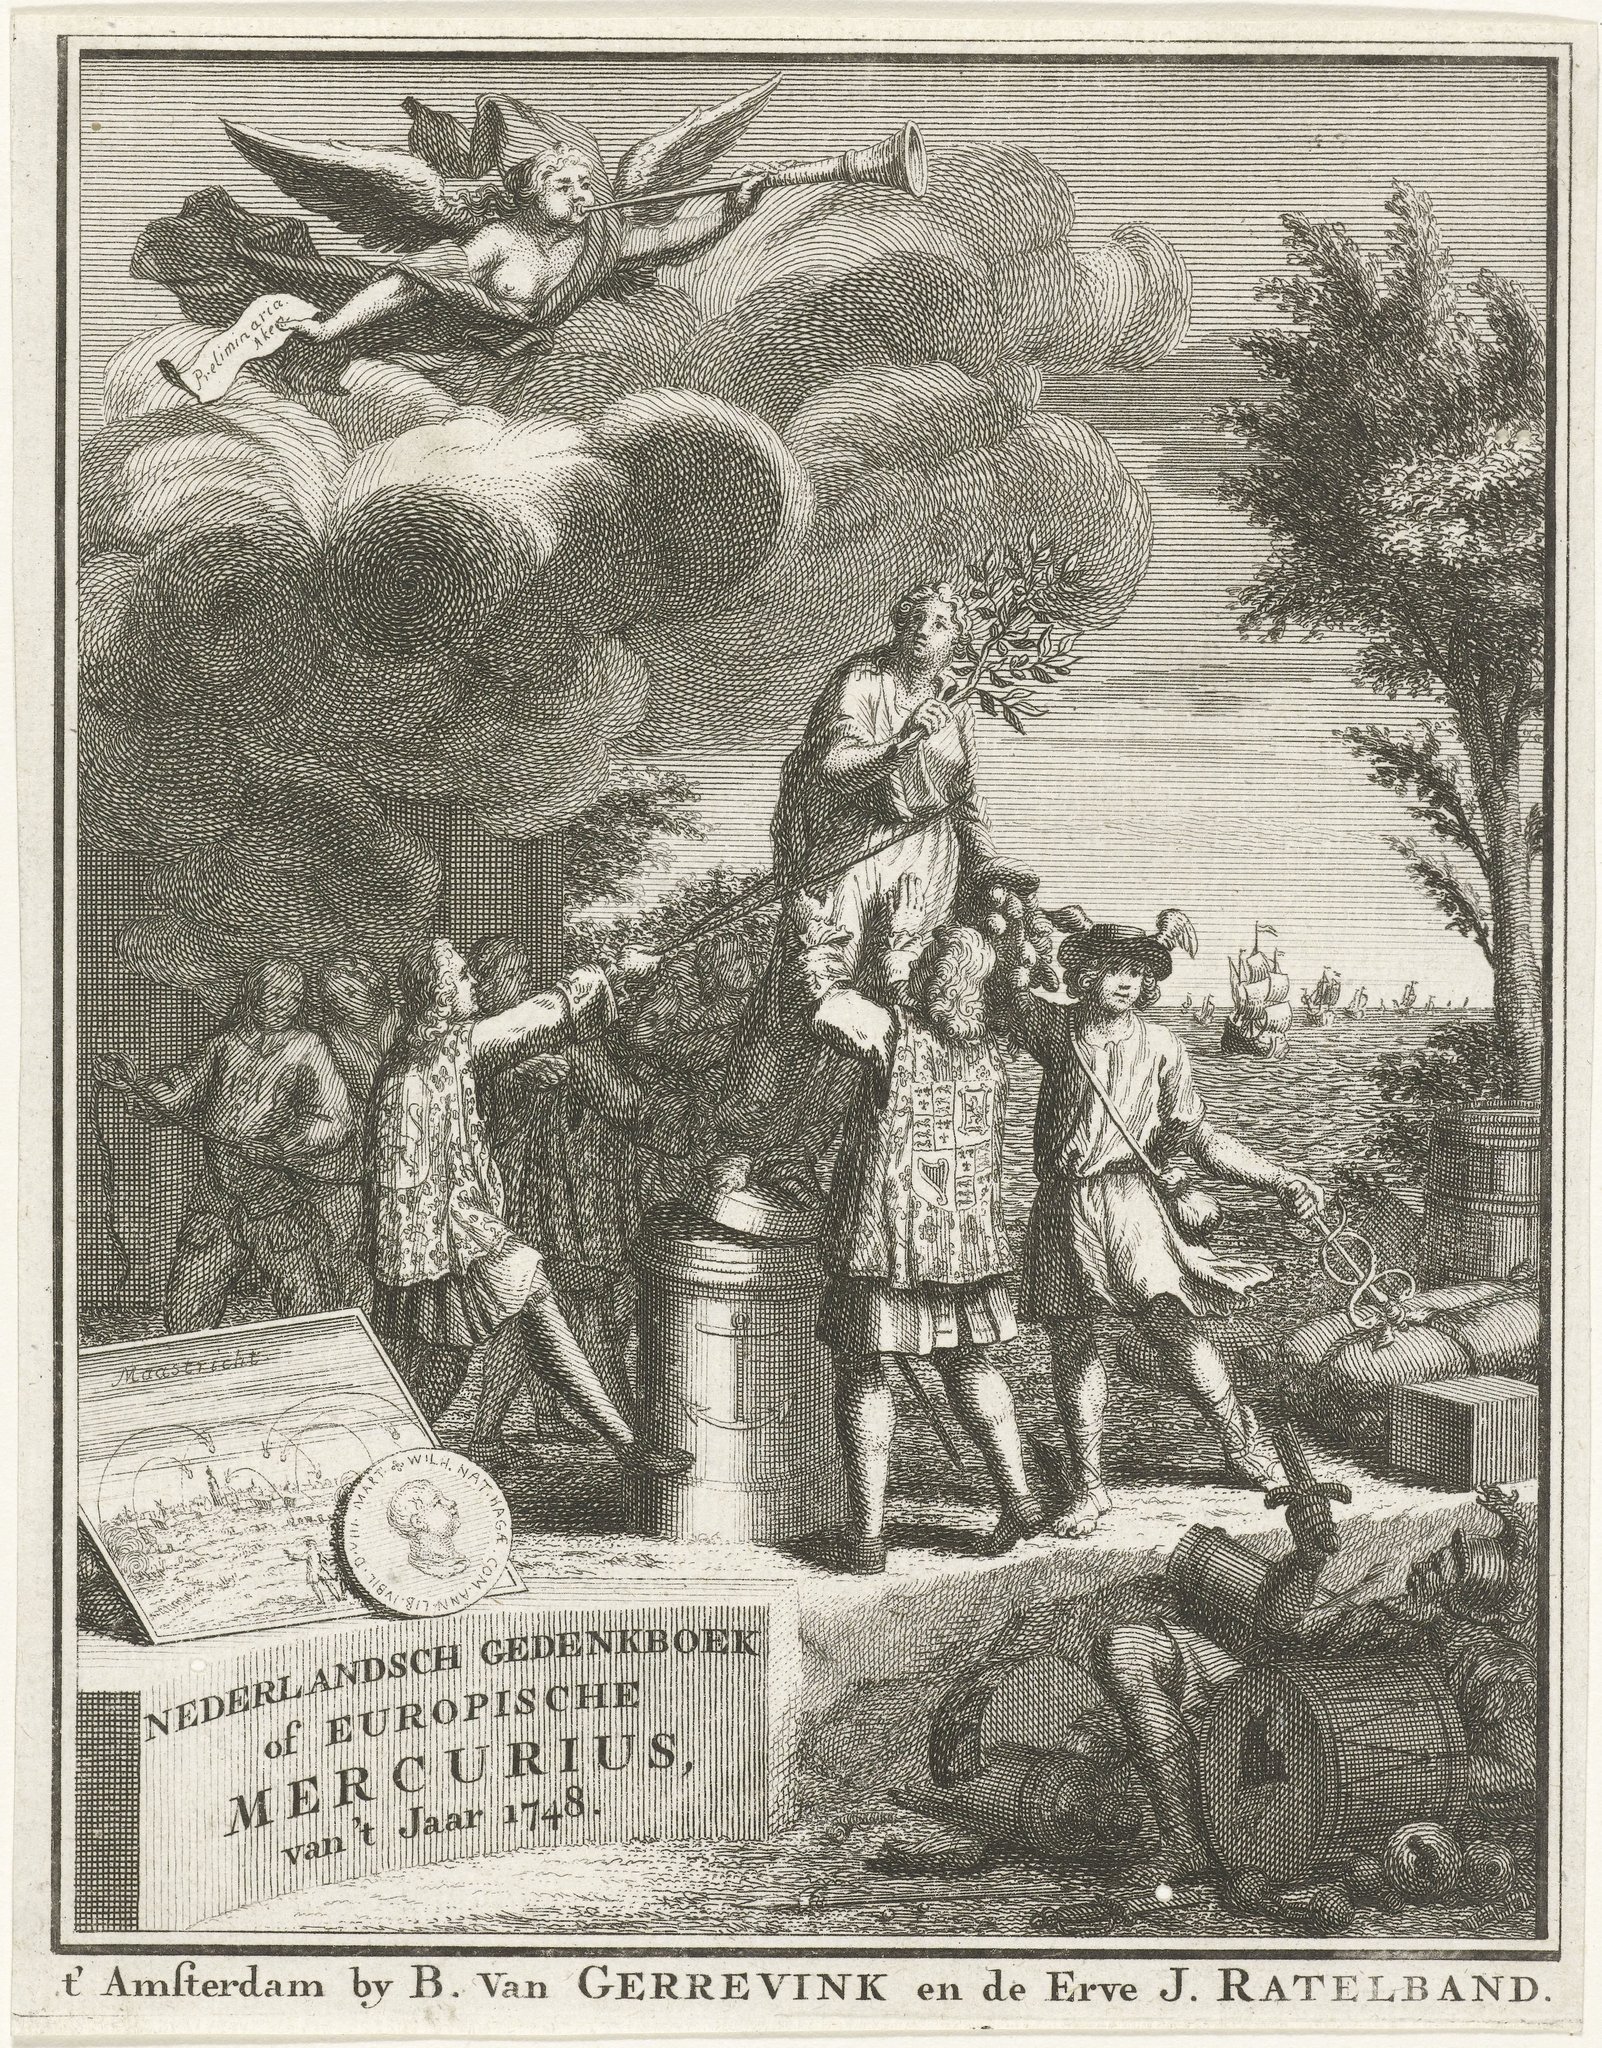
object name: print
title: Titelpagina voor de Europische Mercurius van 1748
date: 1748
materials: paper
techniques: engraving, etching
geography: amsterdam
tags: symbols, allegories of peace, 'pax'; 'pace' (ripa)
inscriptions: collector's mark: Lugt 2228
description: Titelpagina voor het Nederlandsch Gedenkboek of Europische Mercurius, over het jaar 1748. Mercurius ziet zittend toe hoe Nederland en Engeland het standbeeld van de Vrede weer op haar sokkel zetten.